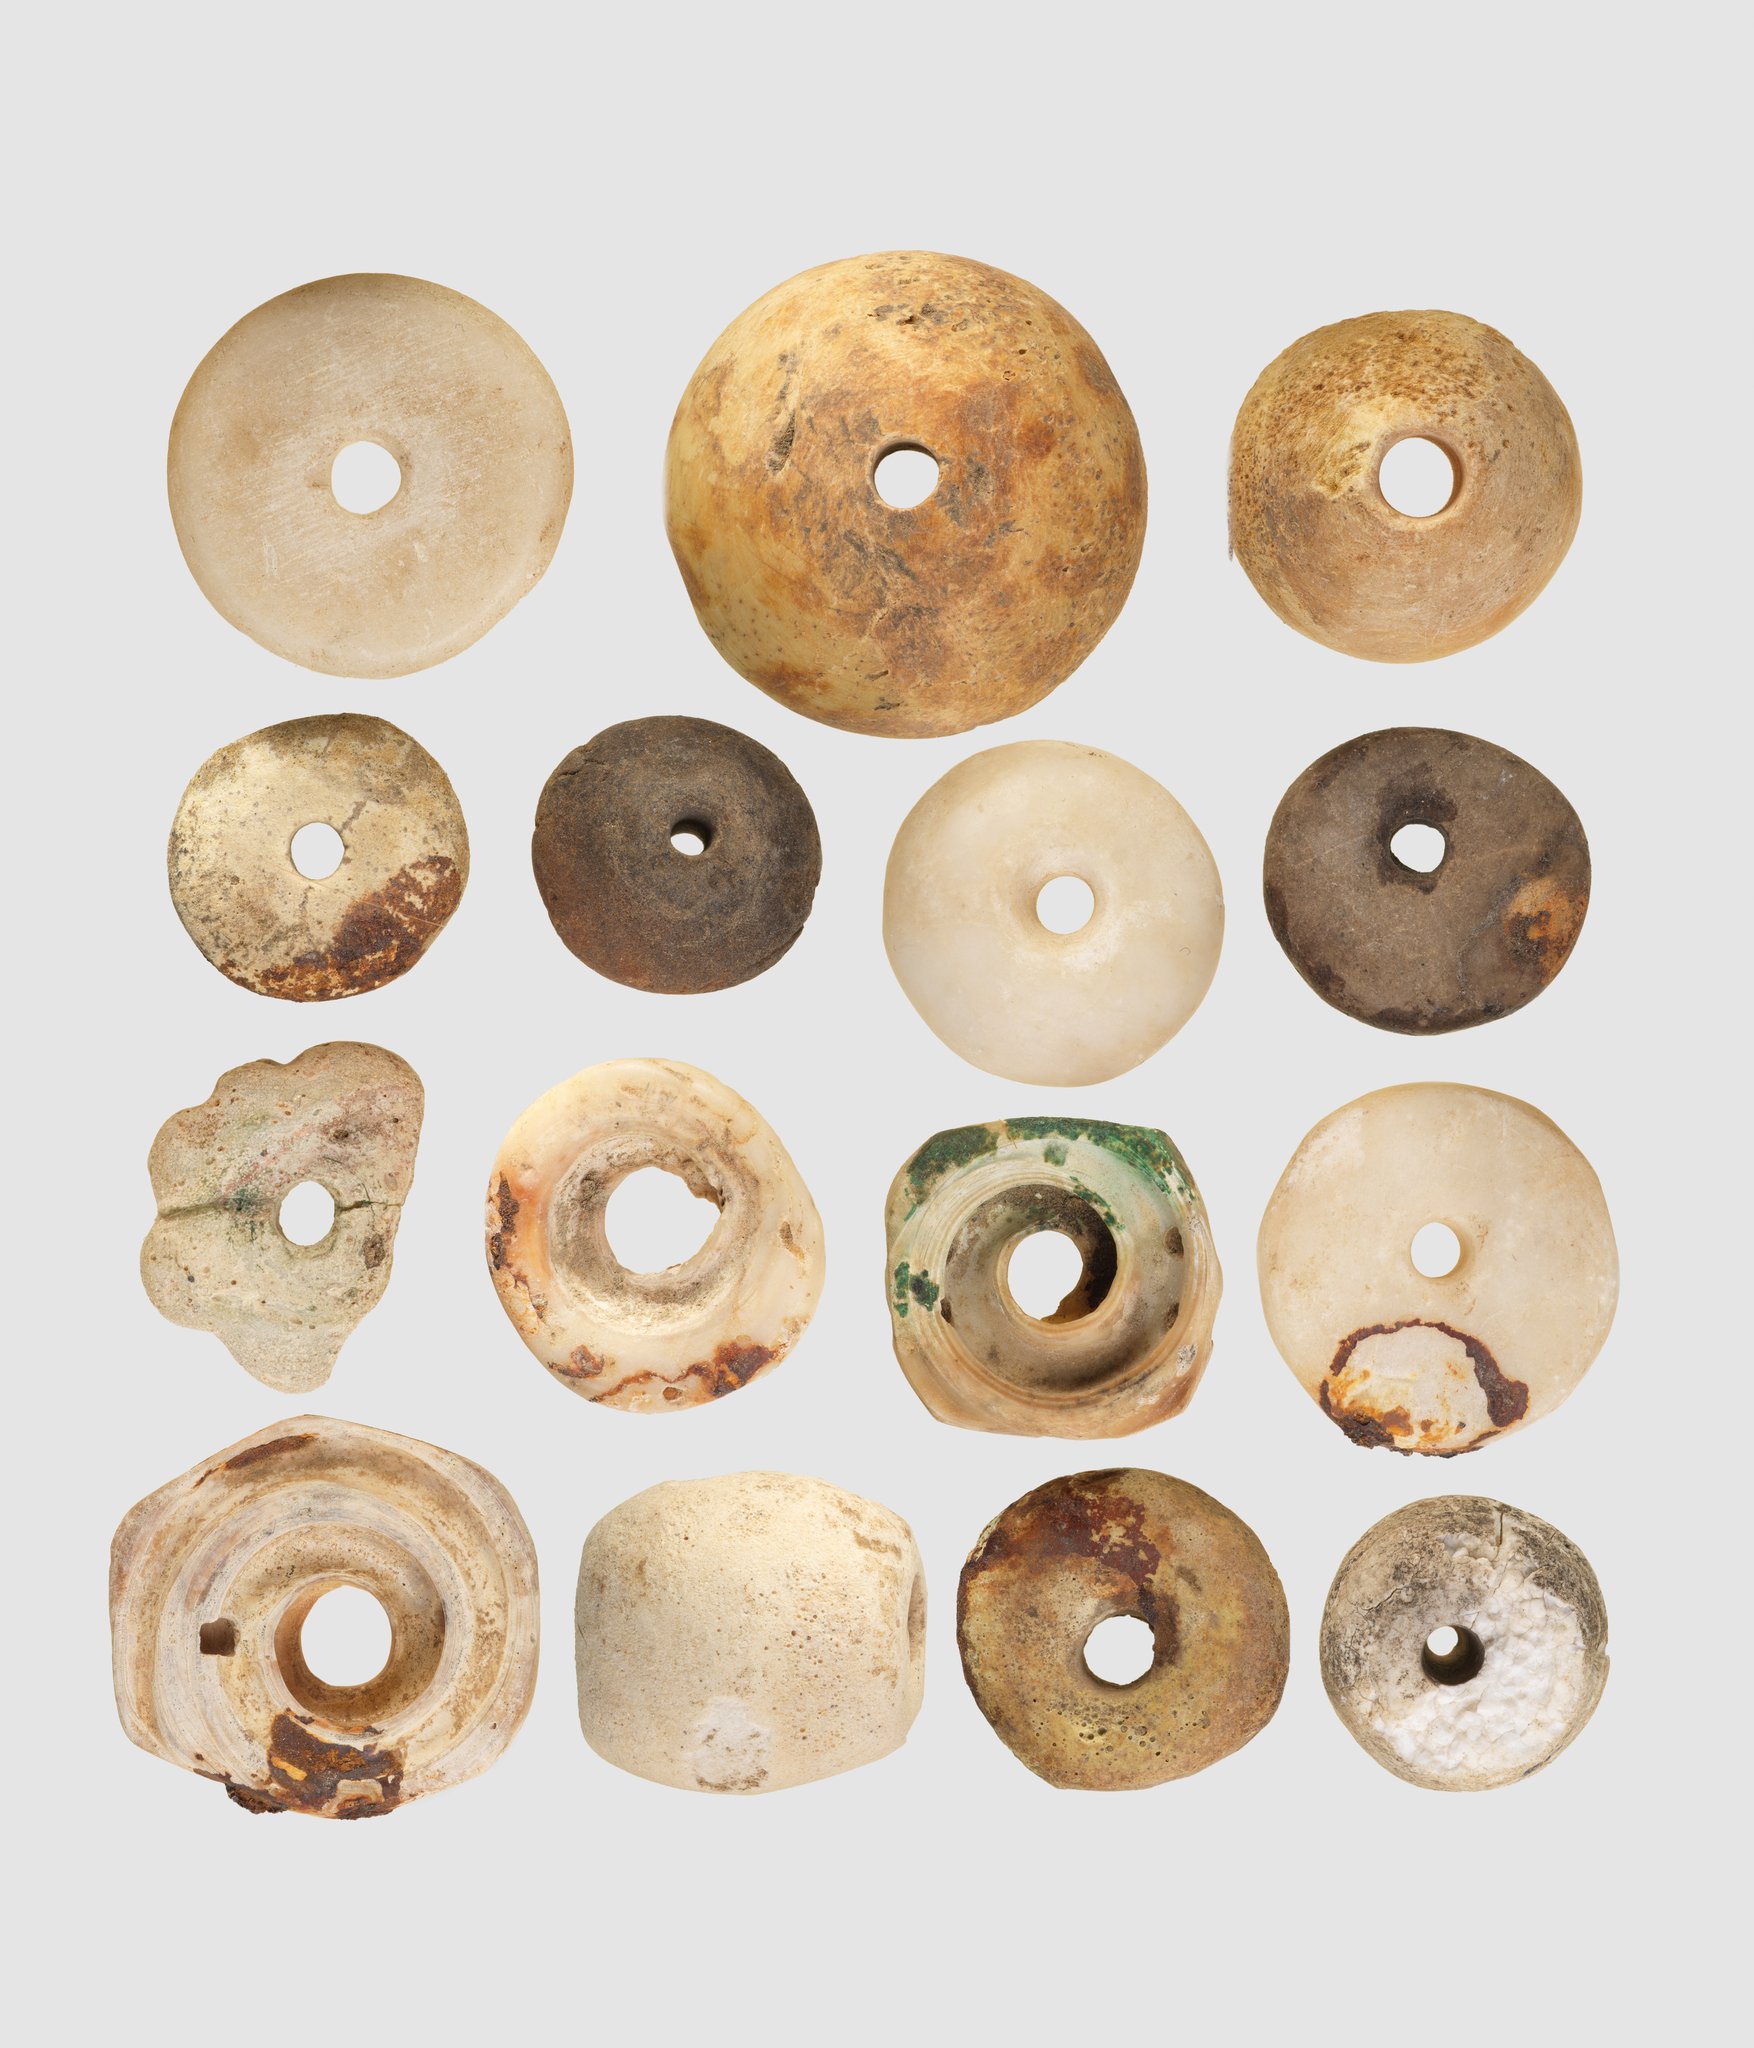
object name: bead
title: Beads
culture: iranian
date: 900-801 BCE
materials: bone, faience, shell, stone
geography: iran